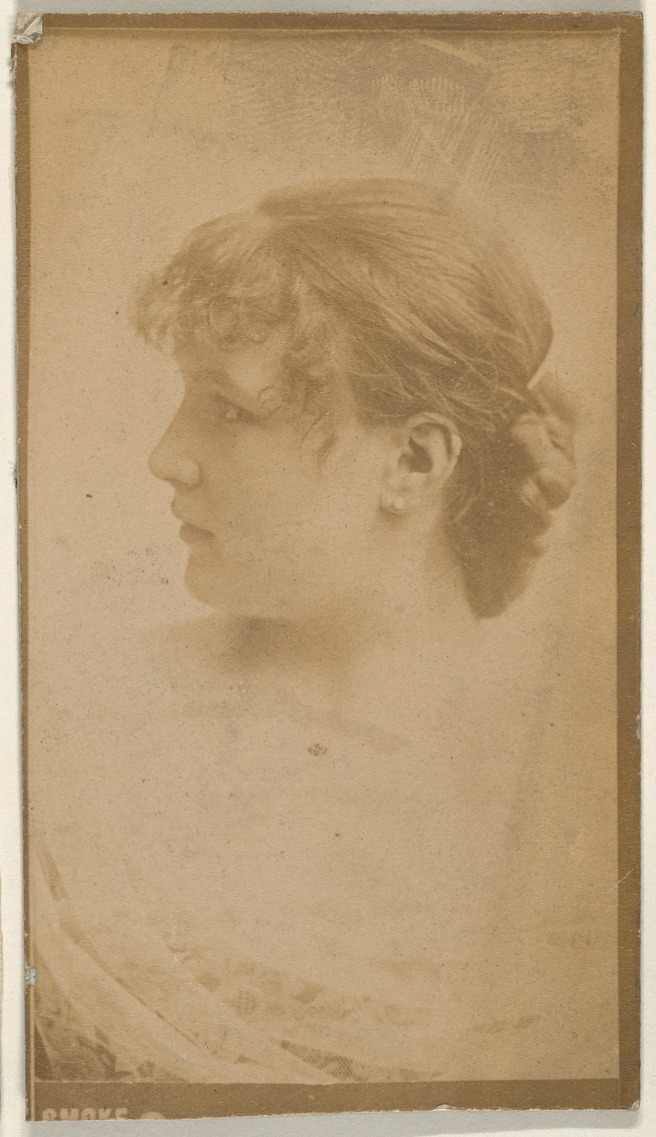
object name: photograph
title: Portrait of actress in profile, from the Actresses series (N668)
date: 1888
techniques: albumen silver print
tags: profiles,women,actresses